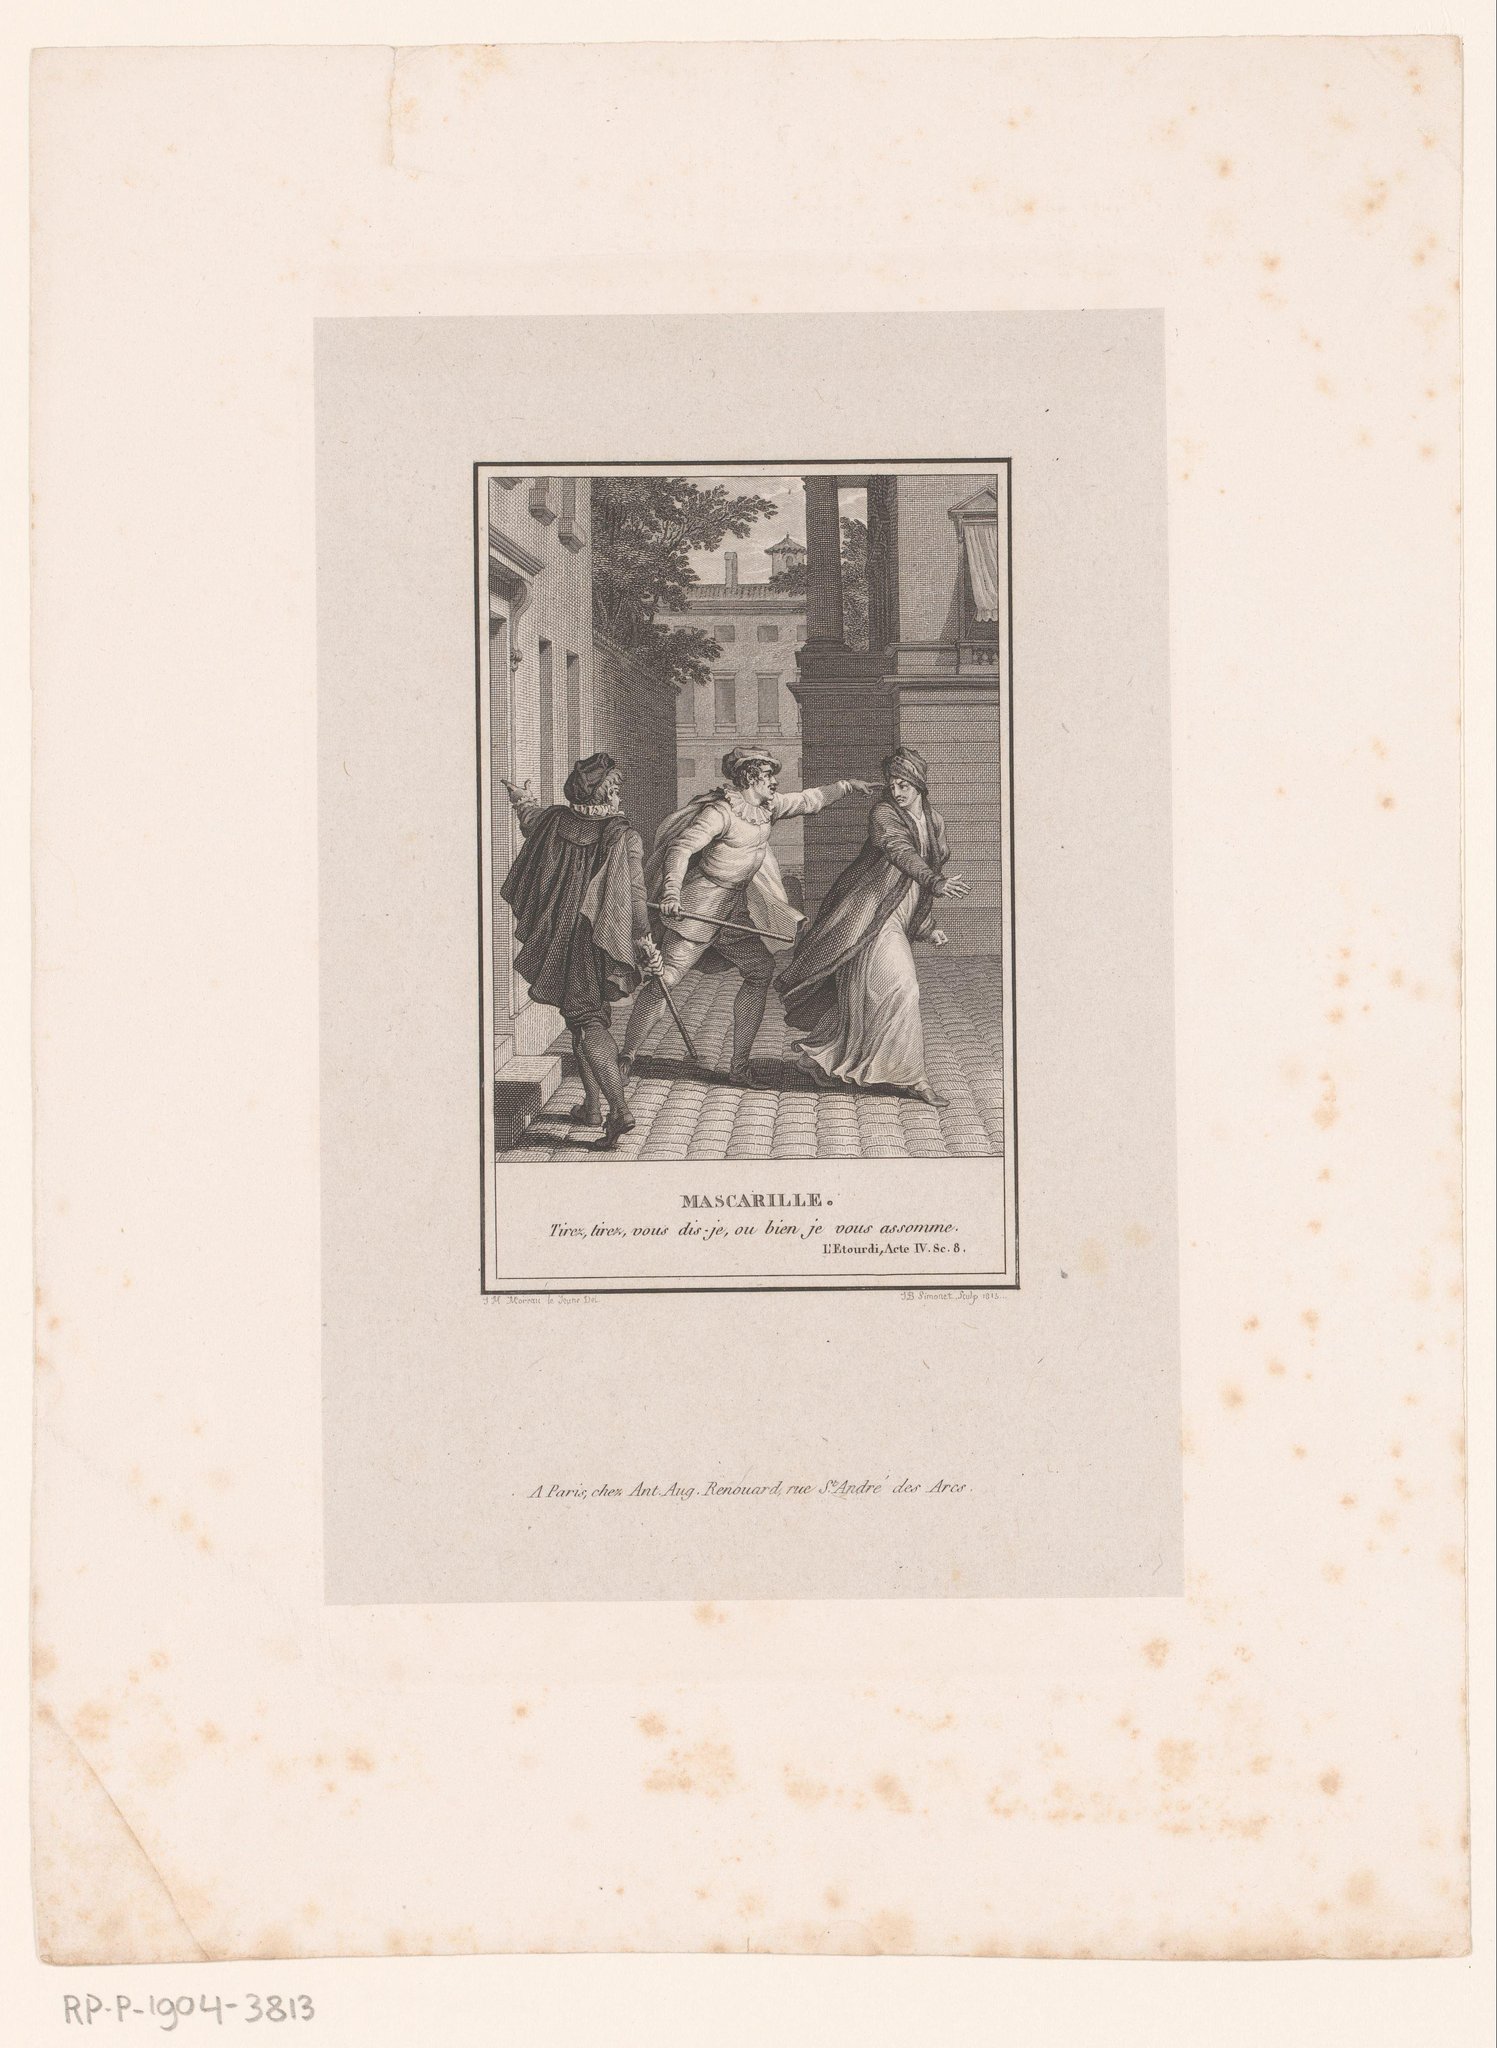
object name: print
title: Mascarille, zittend tussen twee vrouwen, presenteert aan elk van hen een handschoen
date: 1811-1813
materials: paper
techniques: engraving, etching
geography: paris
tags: comedy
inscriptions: collector's mark: Lugt 2228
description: Prent van scène tien uit 'Les Précieuses ridicules' door Jean Baptiste Molière. Dit betreft één van de dertig prenten, gemaakt in opdracht van Antoine Augustin Renouard, bestemd voor verschillende edities van Molières werk daterend van 1811 tot 1813. De prenten zijn vervaardigd door verschillende kunstenaars naar composities van Moreau.